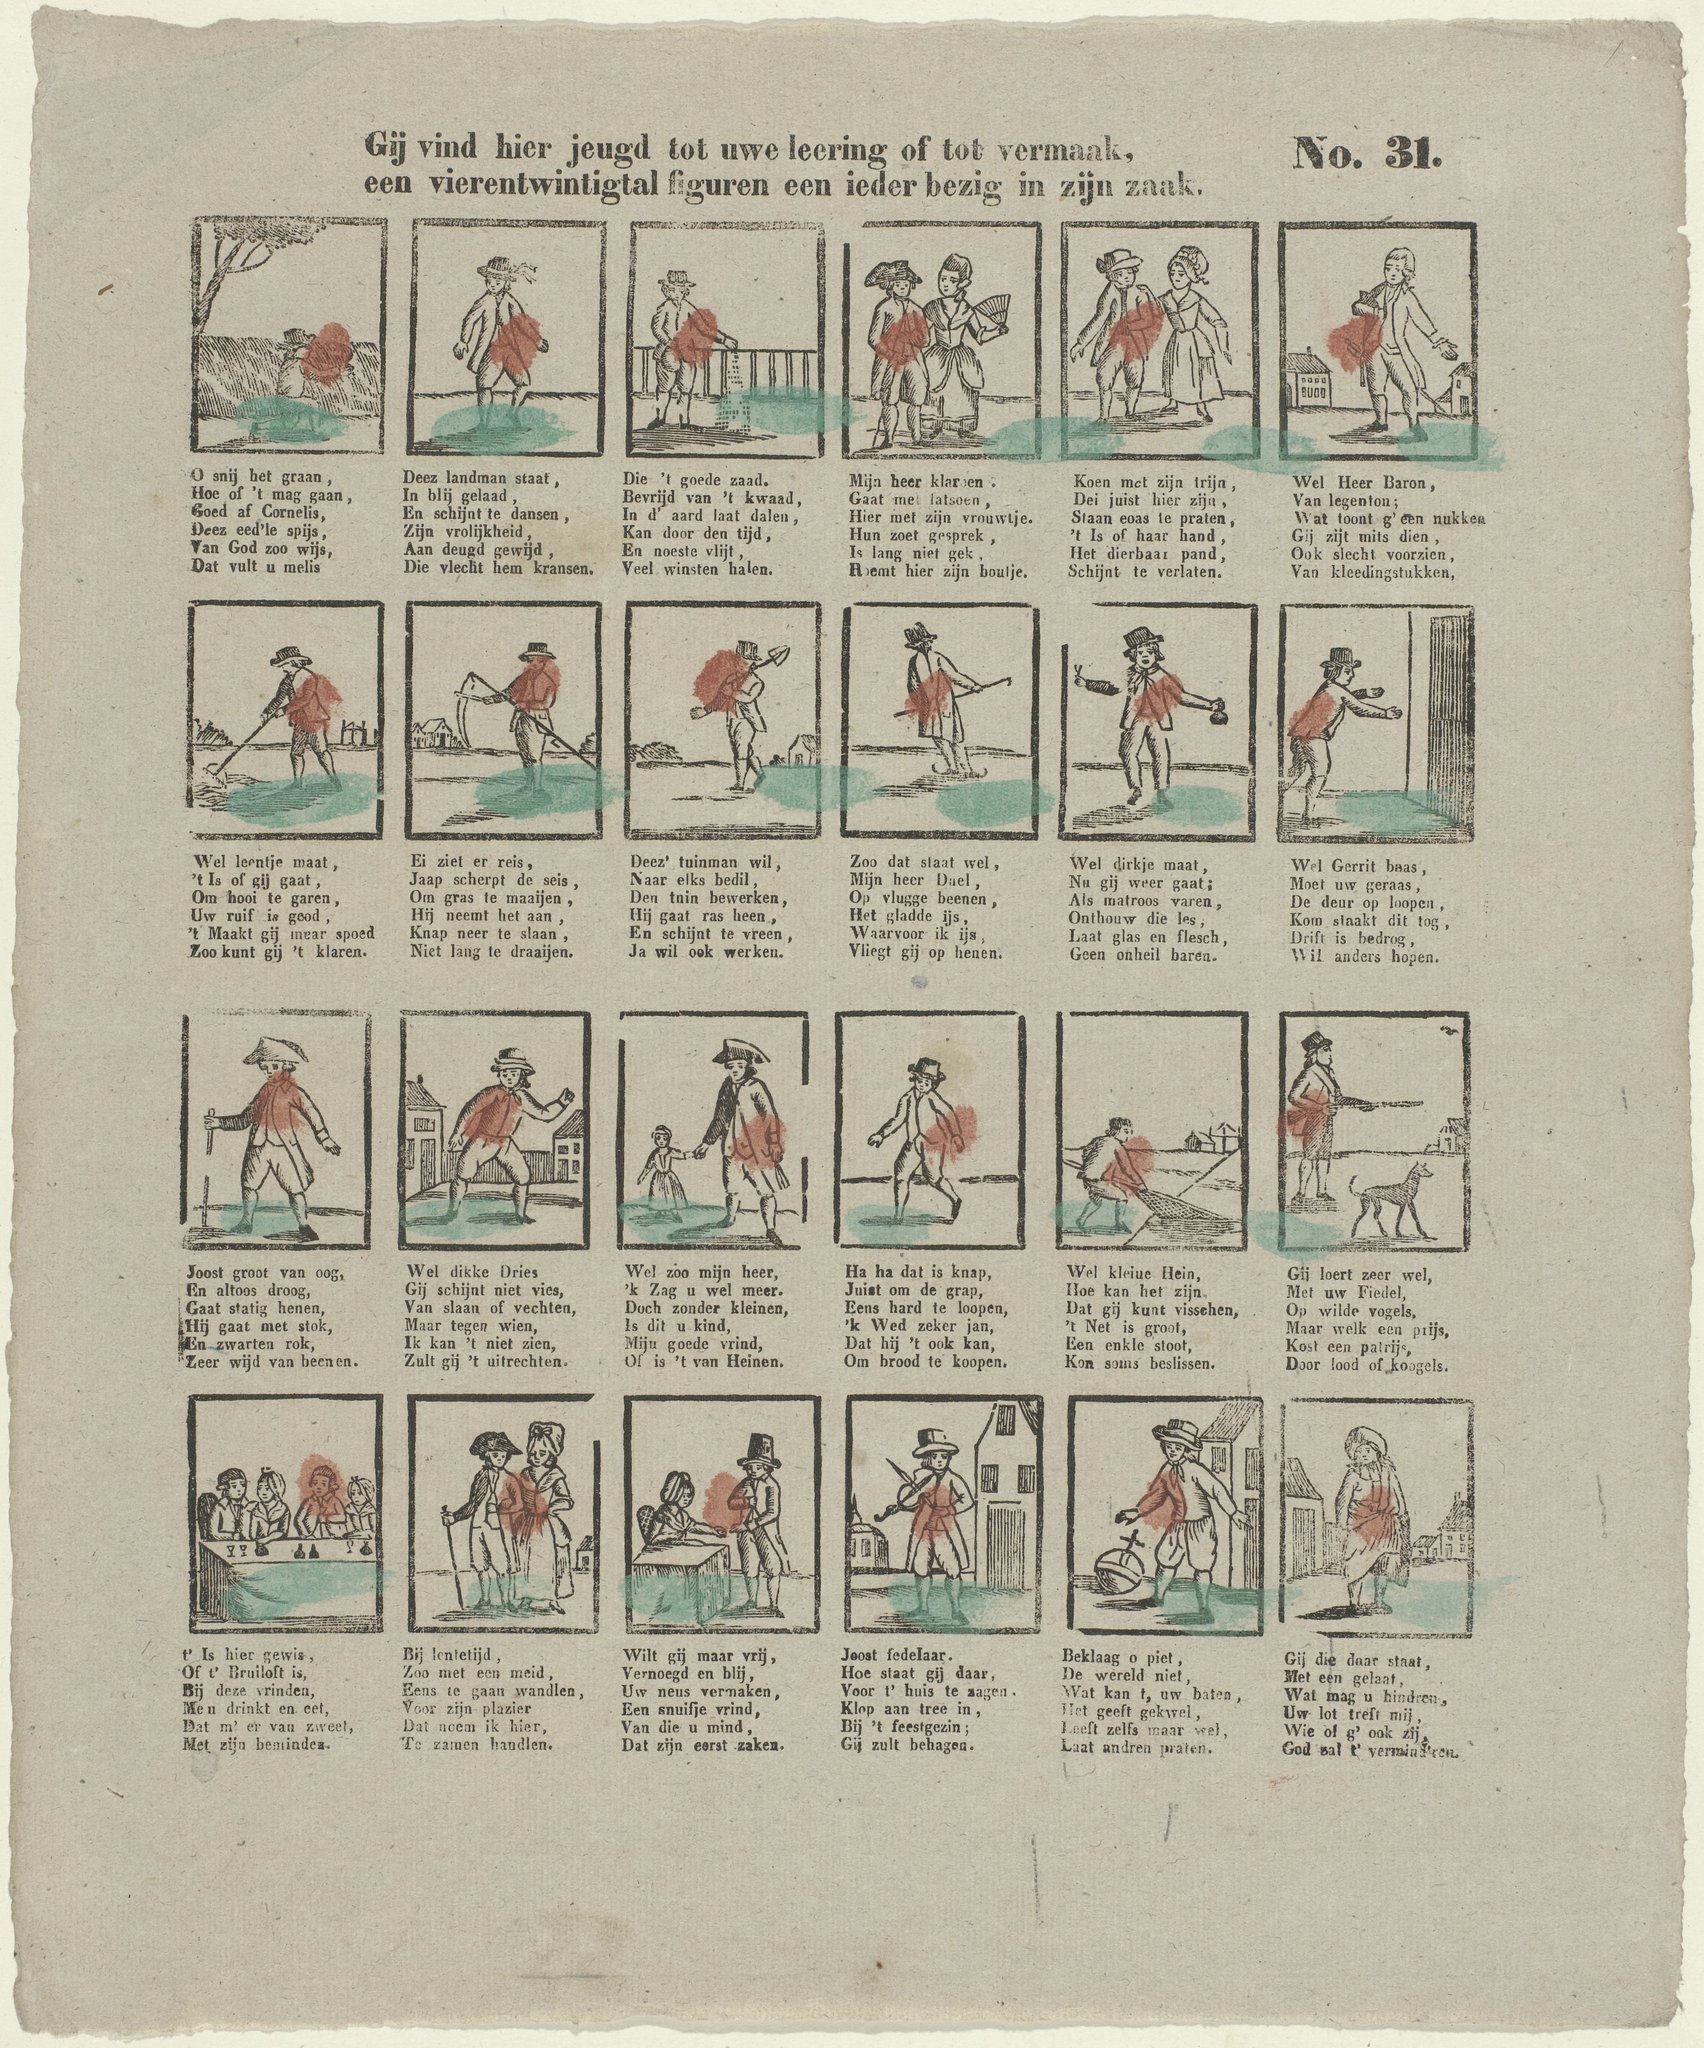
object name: popular print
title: Gij vind hier jeugd tot uwe leering of tot vermaak, / een vierentwintigtal figuren een ieder bezig in zijn zaak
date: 1832-1850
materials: paper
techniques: colour, letterpress printing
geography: rotterdam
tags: craft-production, skilled handiwork, street-trader, agriculture, crafts and industries, merchant, salesman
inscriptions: collector's mark: Lugt 2760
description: Blad met 24 voorstellingen van ambachten, beroepen en bezigheden, zoals zaaien, vechten en vioolspelen. Onder elke afbeelding een zesregelig vers. Genummerd rechtsboven: No. 31.